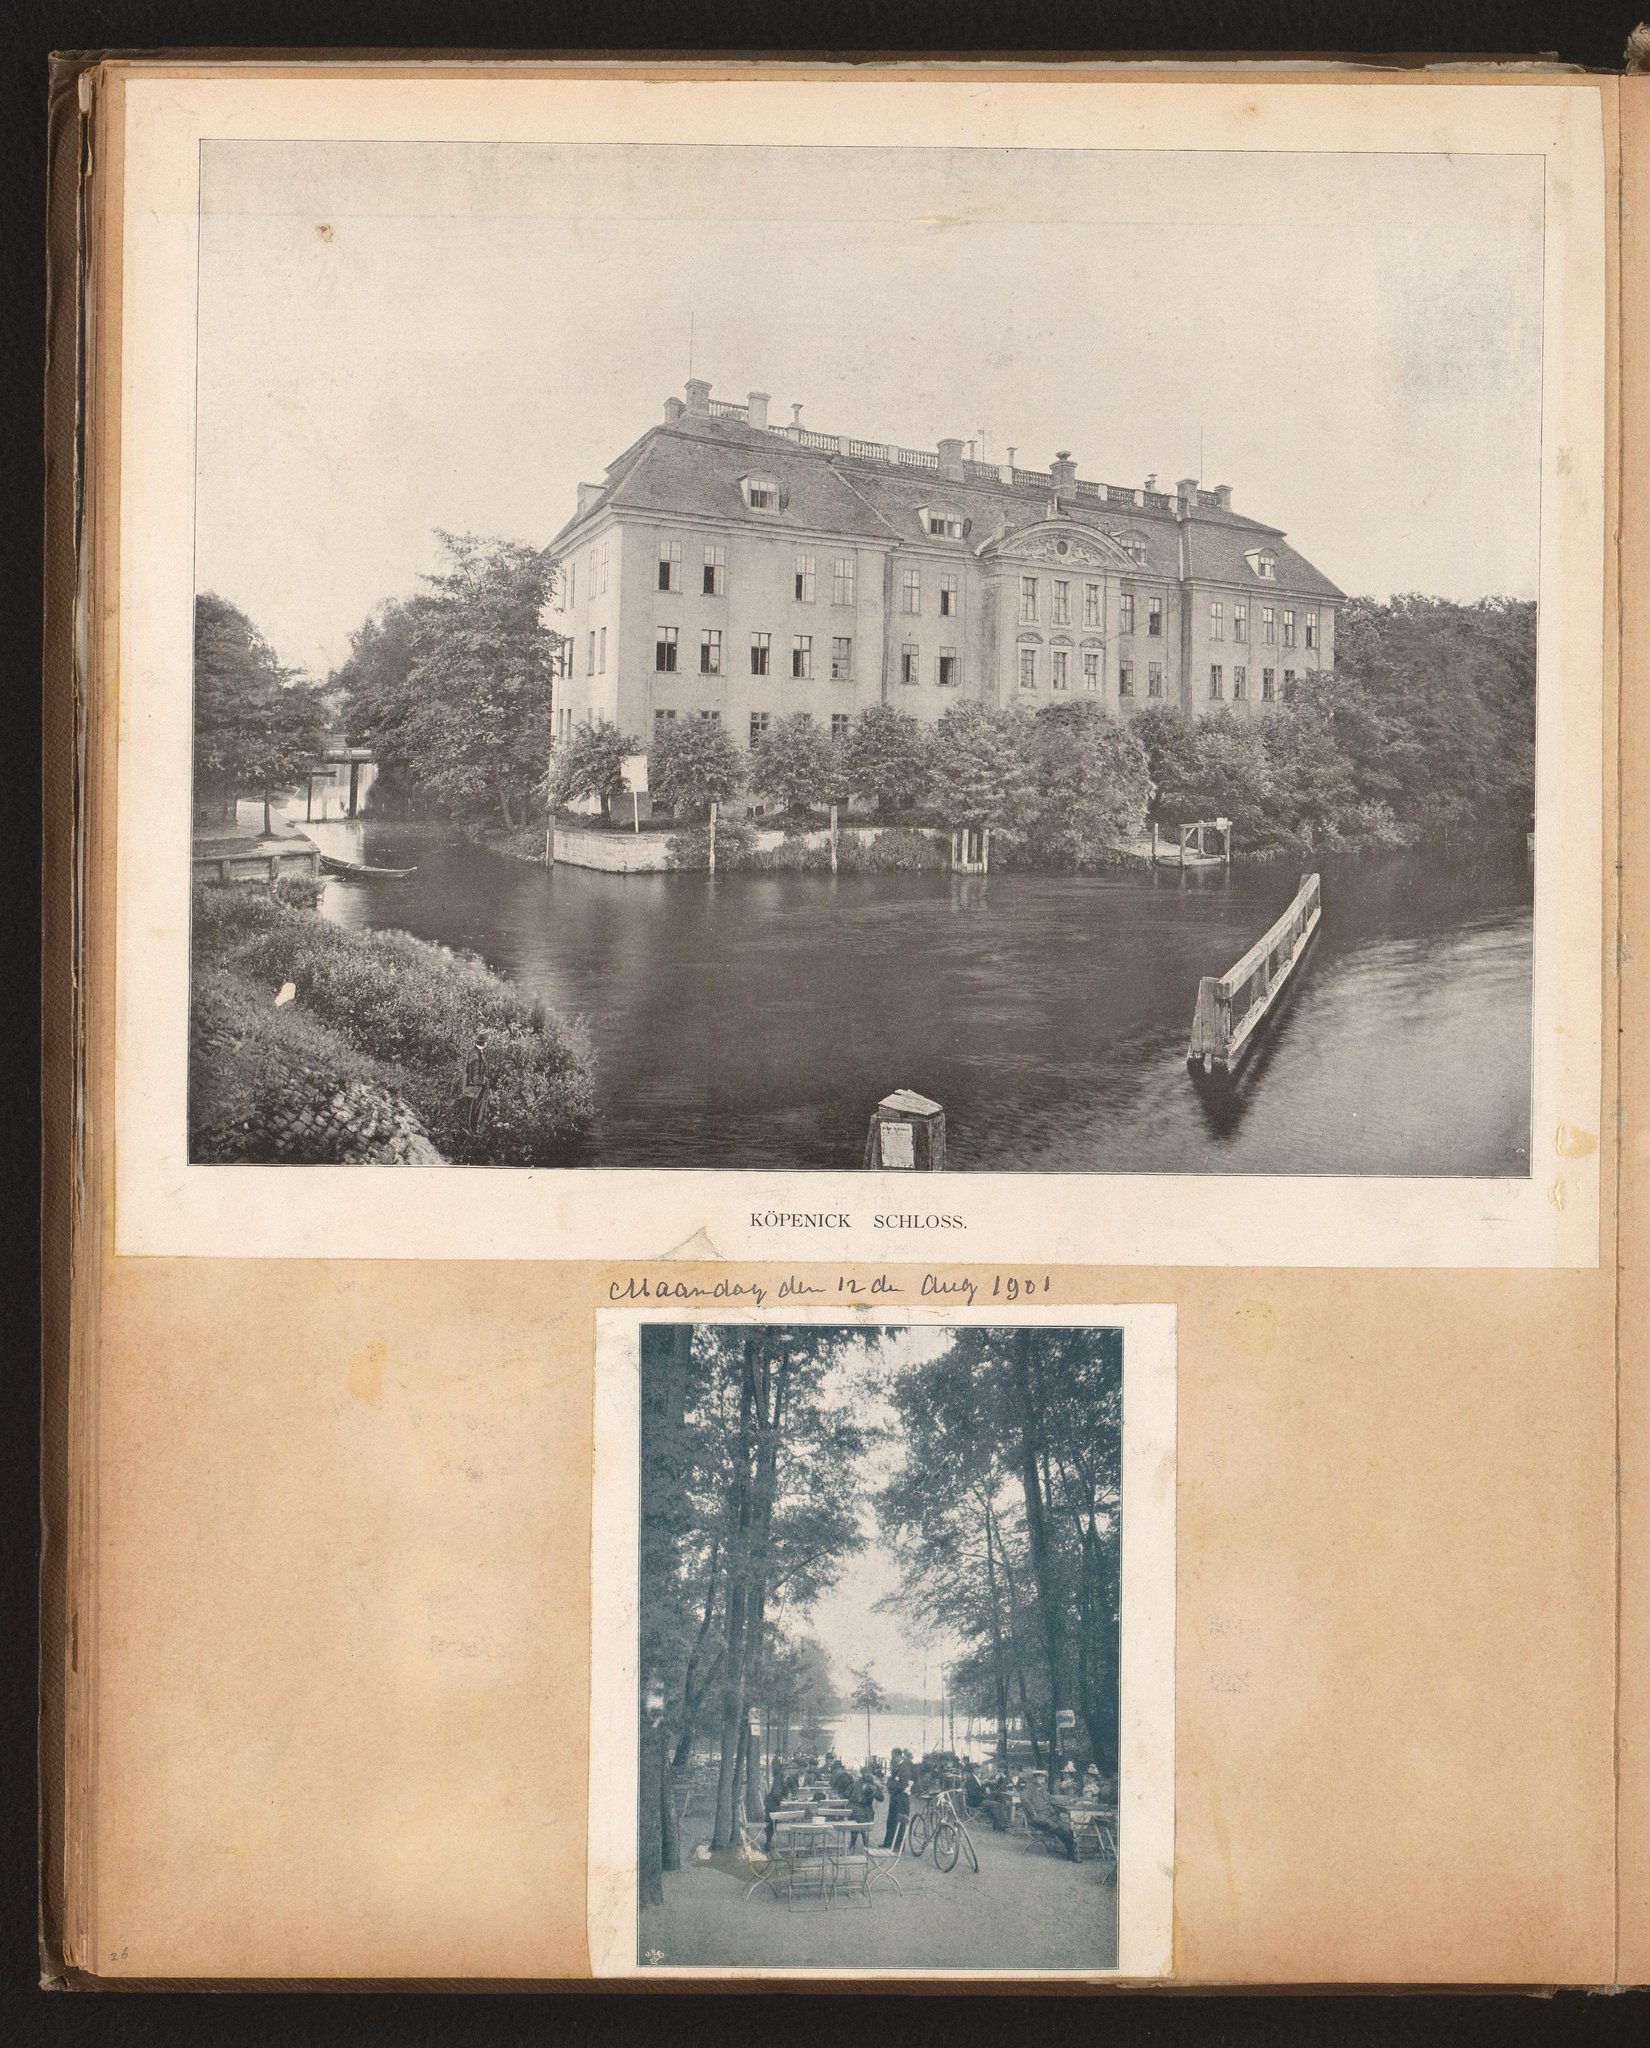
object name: album leaf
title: Schloss Köpenick en een terras onder bomen in Köpenick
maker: Anonymous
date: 1896-1901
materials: paper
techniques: autotype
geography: köpenick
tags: castle, pavement, terrace in front of inn or restaurant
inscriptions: inscription: ‘Maandag den 12de Aug 1901’, title: ‘Köpenick Schloss.’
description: Deze fotomechanische afdrukken maken deel uit van een album.